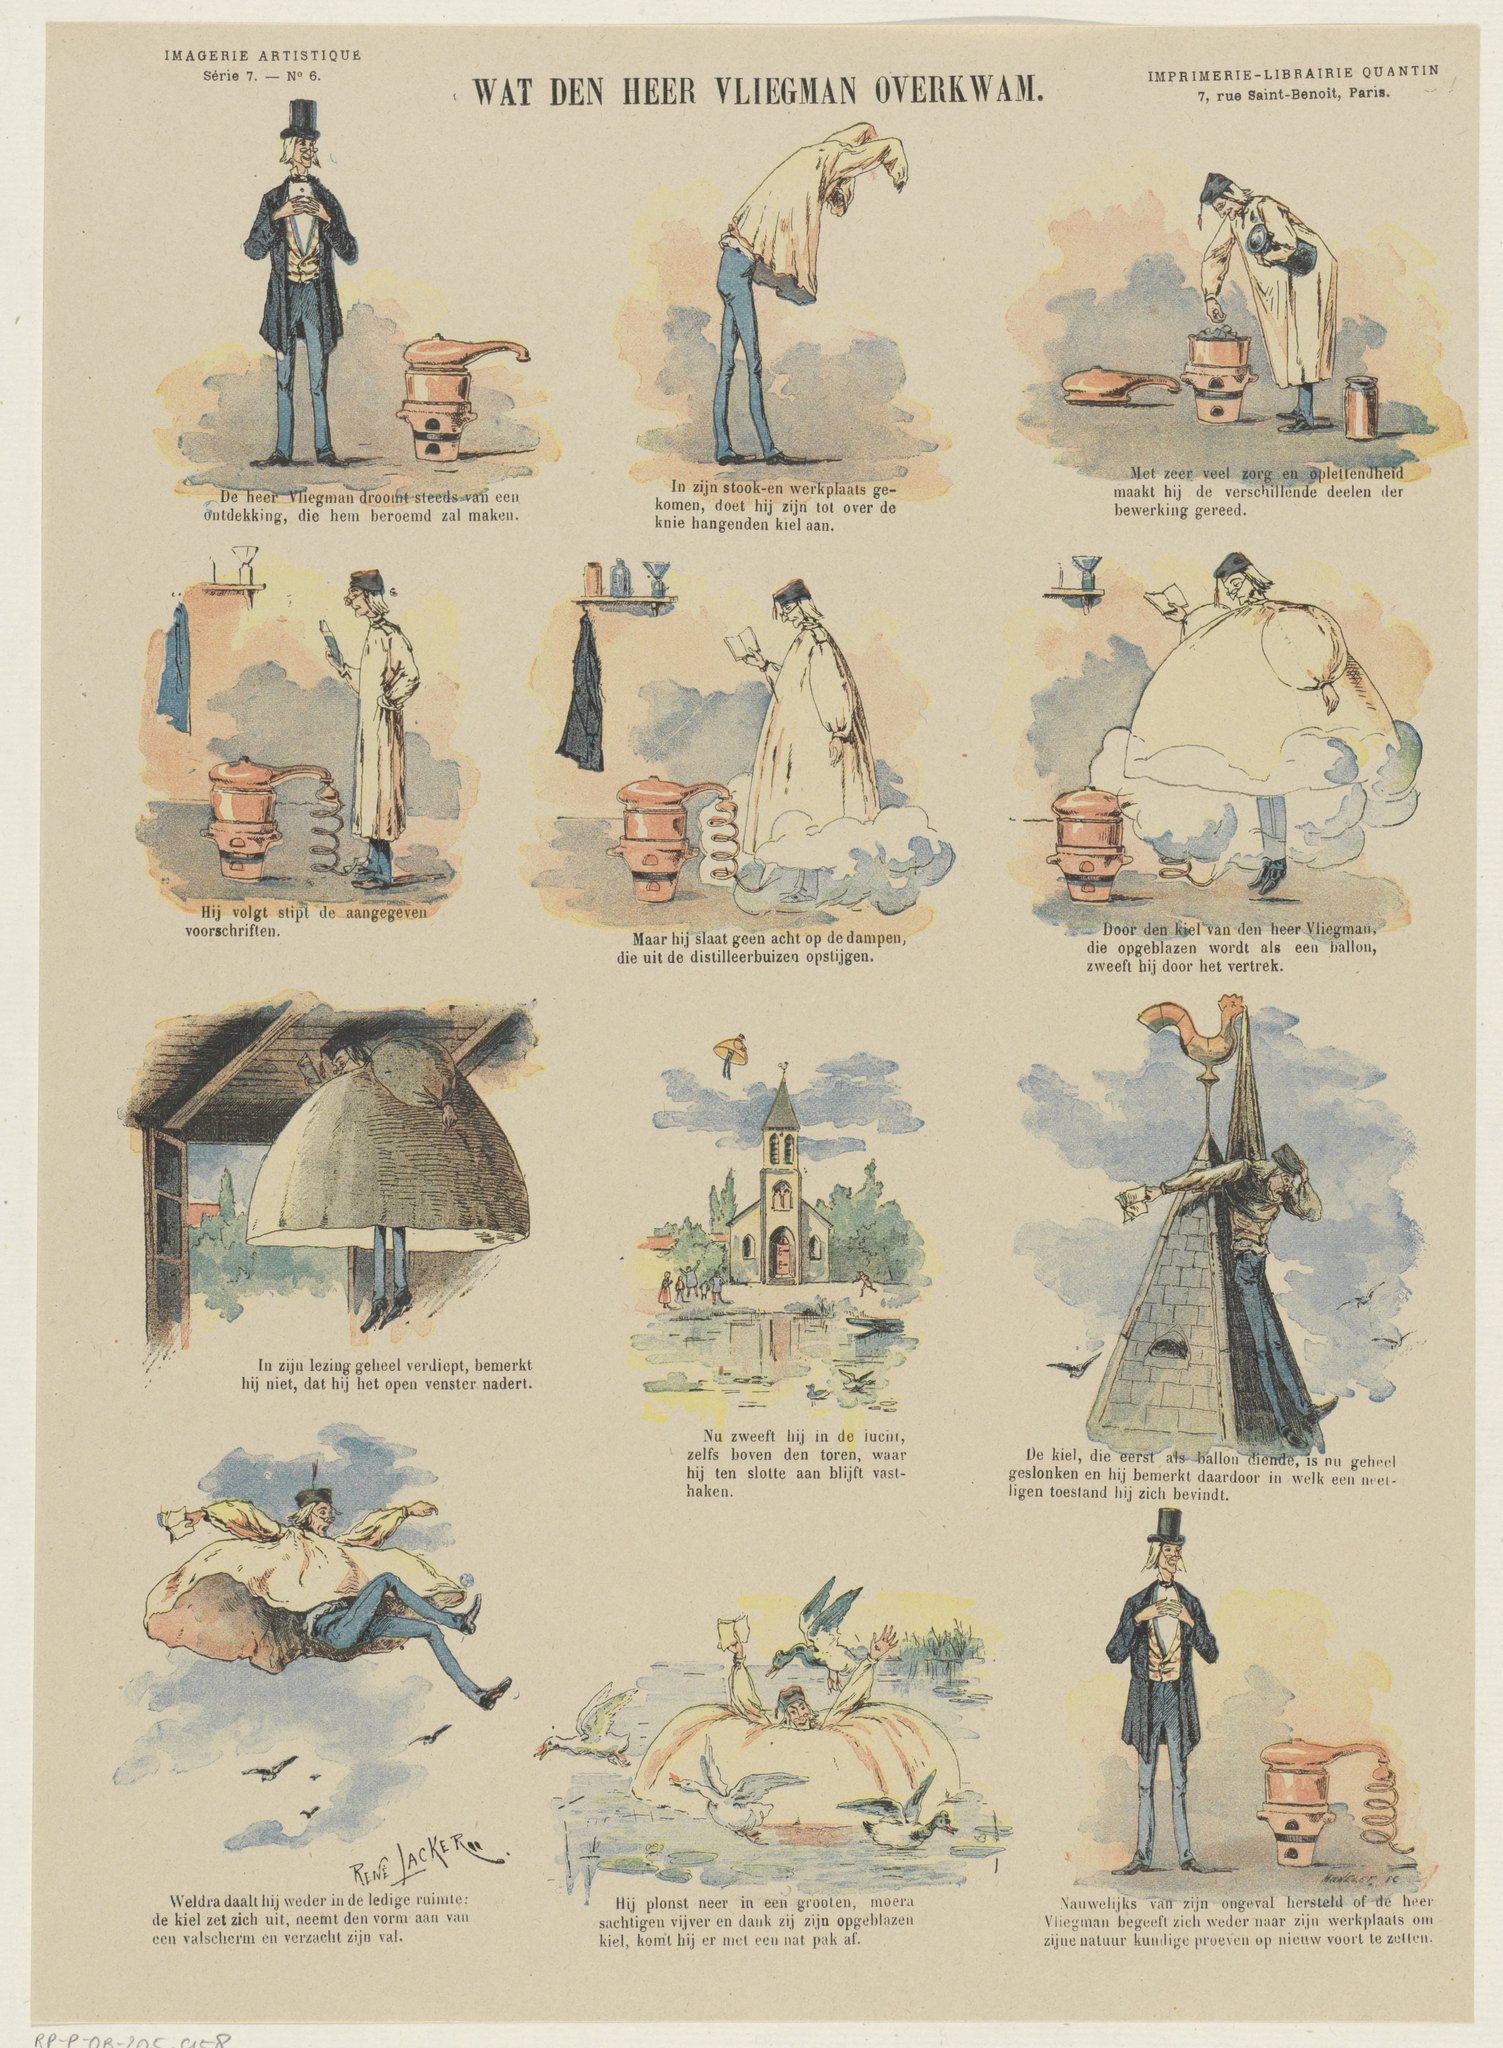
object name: print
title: Wat den heer Vliegman overkwam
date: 1876-1890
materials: paper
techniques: lithograph, letterpress printing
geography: paris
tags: flying, tales and fairy tales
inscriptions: collector's mark: Lugt 2760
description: Blad met 12 voorstellingen van de heer Vliegman die gaat zweven. Onder elke voorstelling een onderschrift. Genummerd linksboven: Série 7. - No. 6.